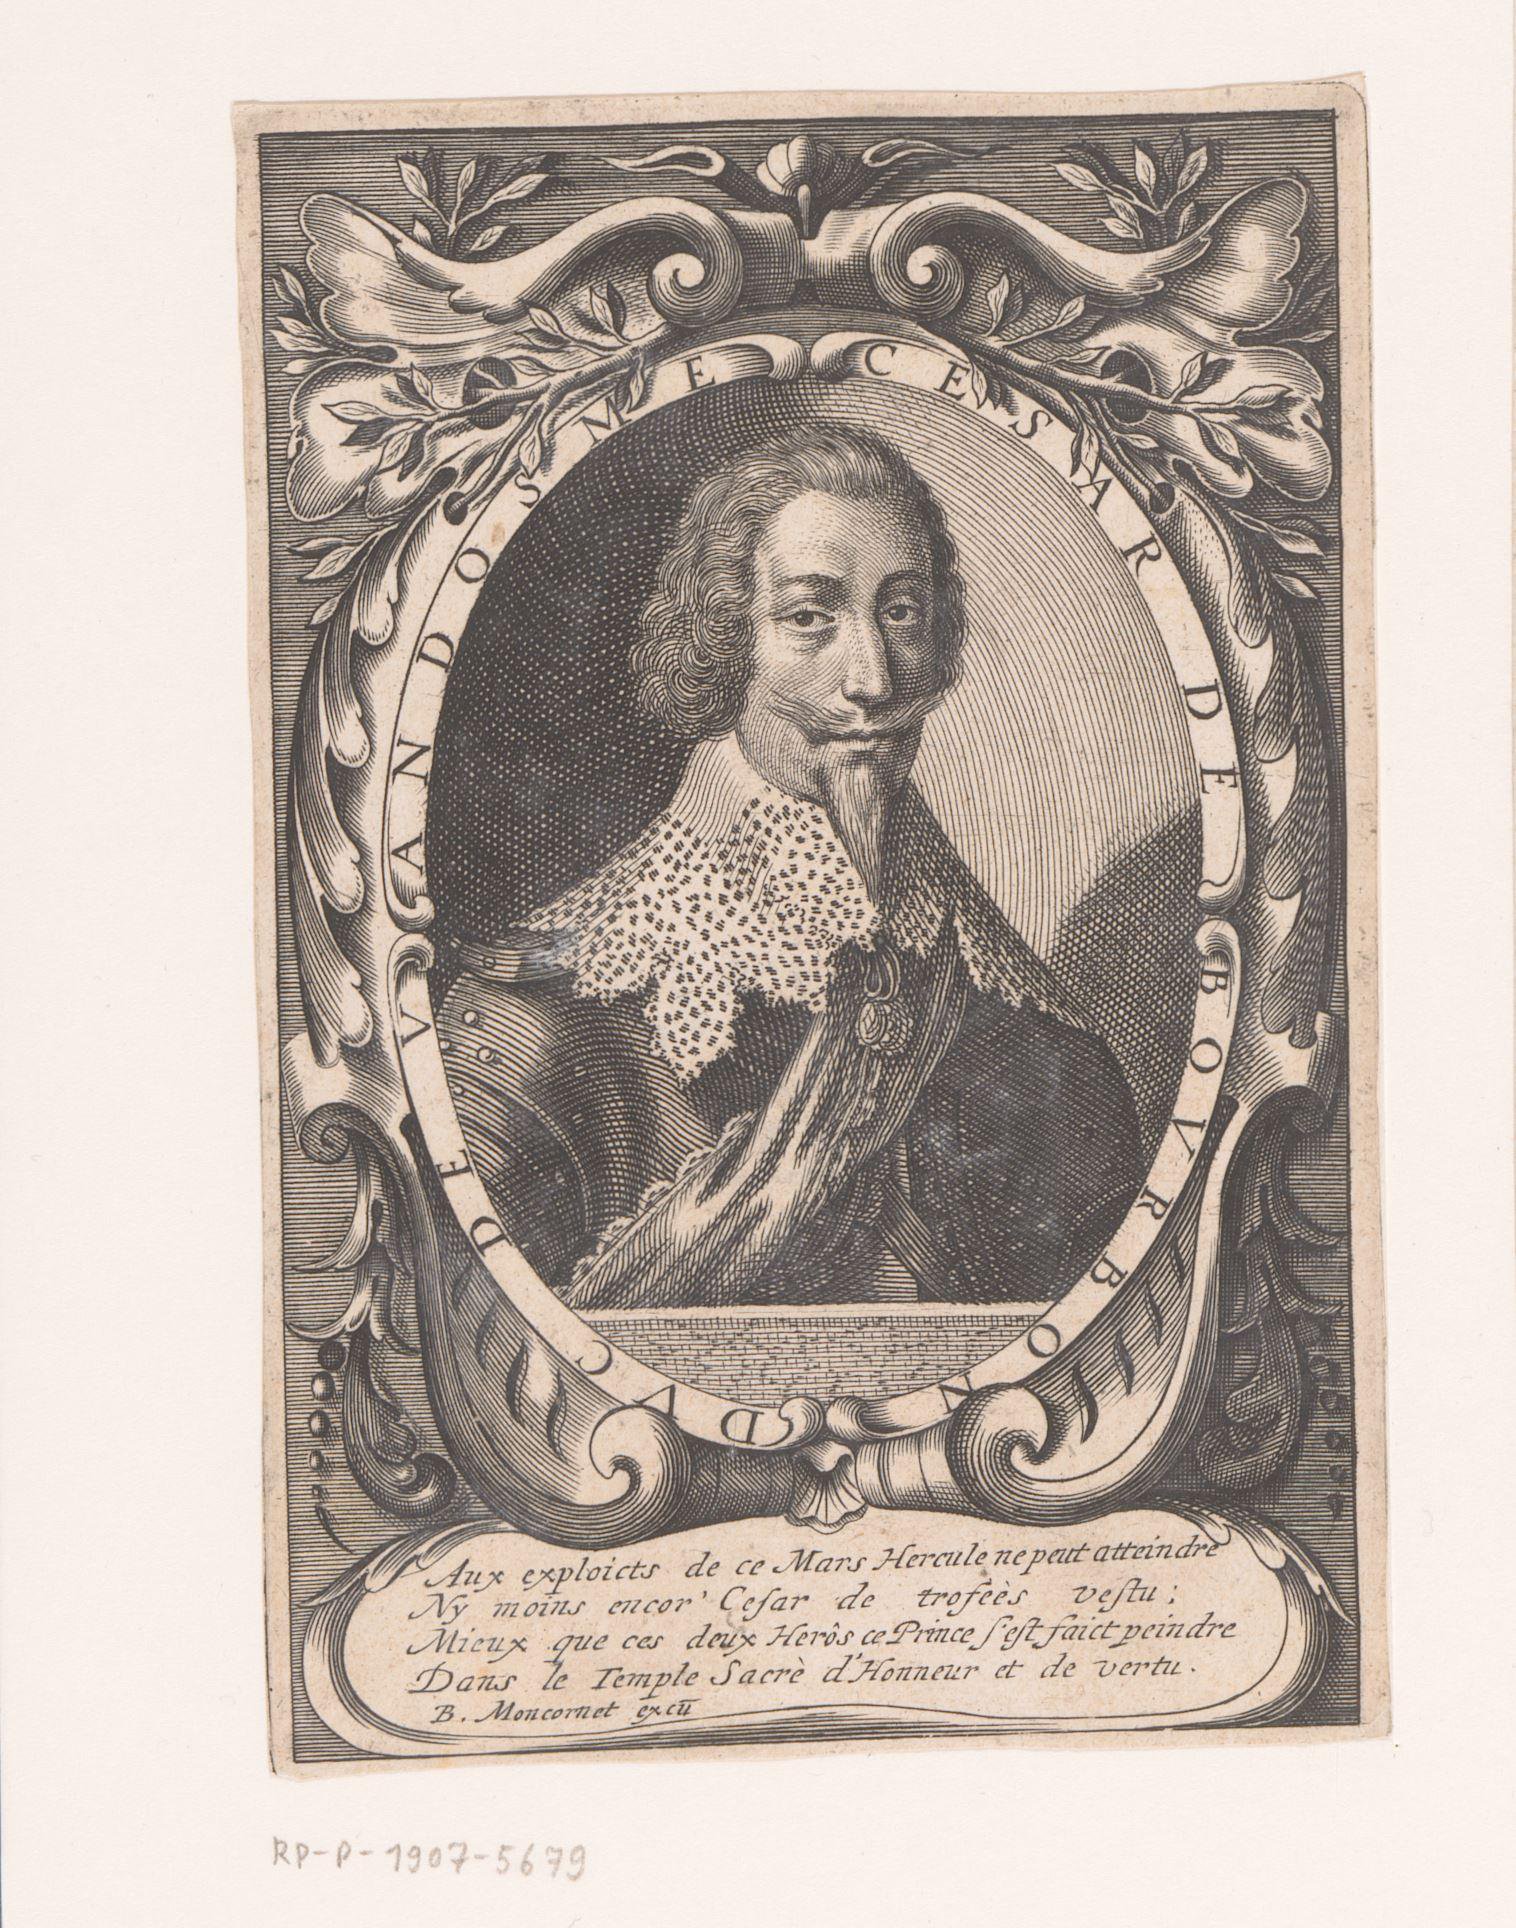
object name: print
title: Portret van Caesar van Vendôme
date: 1610-1668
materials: paper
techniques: engraving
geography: paris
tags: paris, historical persons, nobility and patriciate; chivalry, knighthood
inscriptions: collector's mark: Lugt 2228